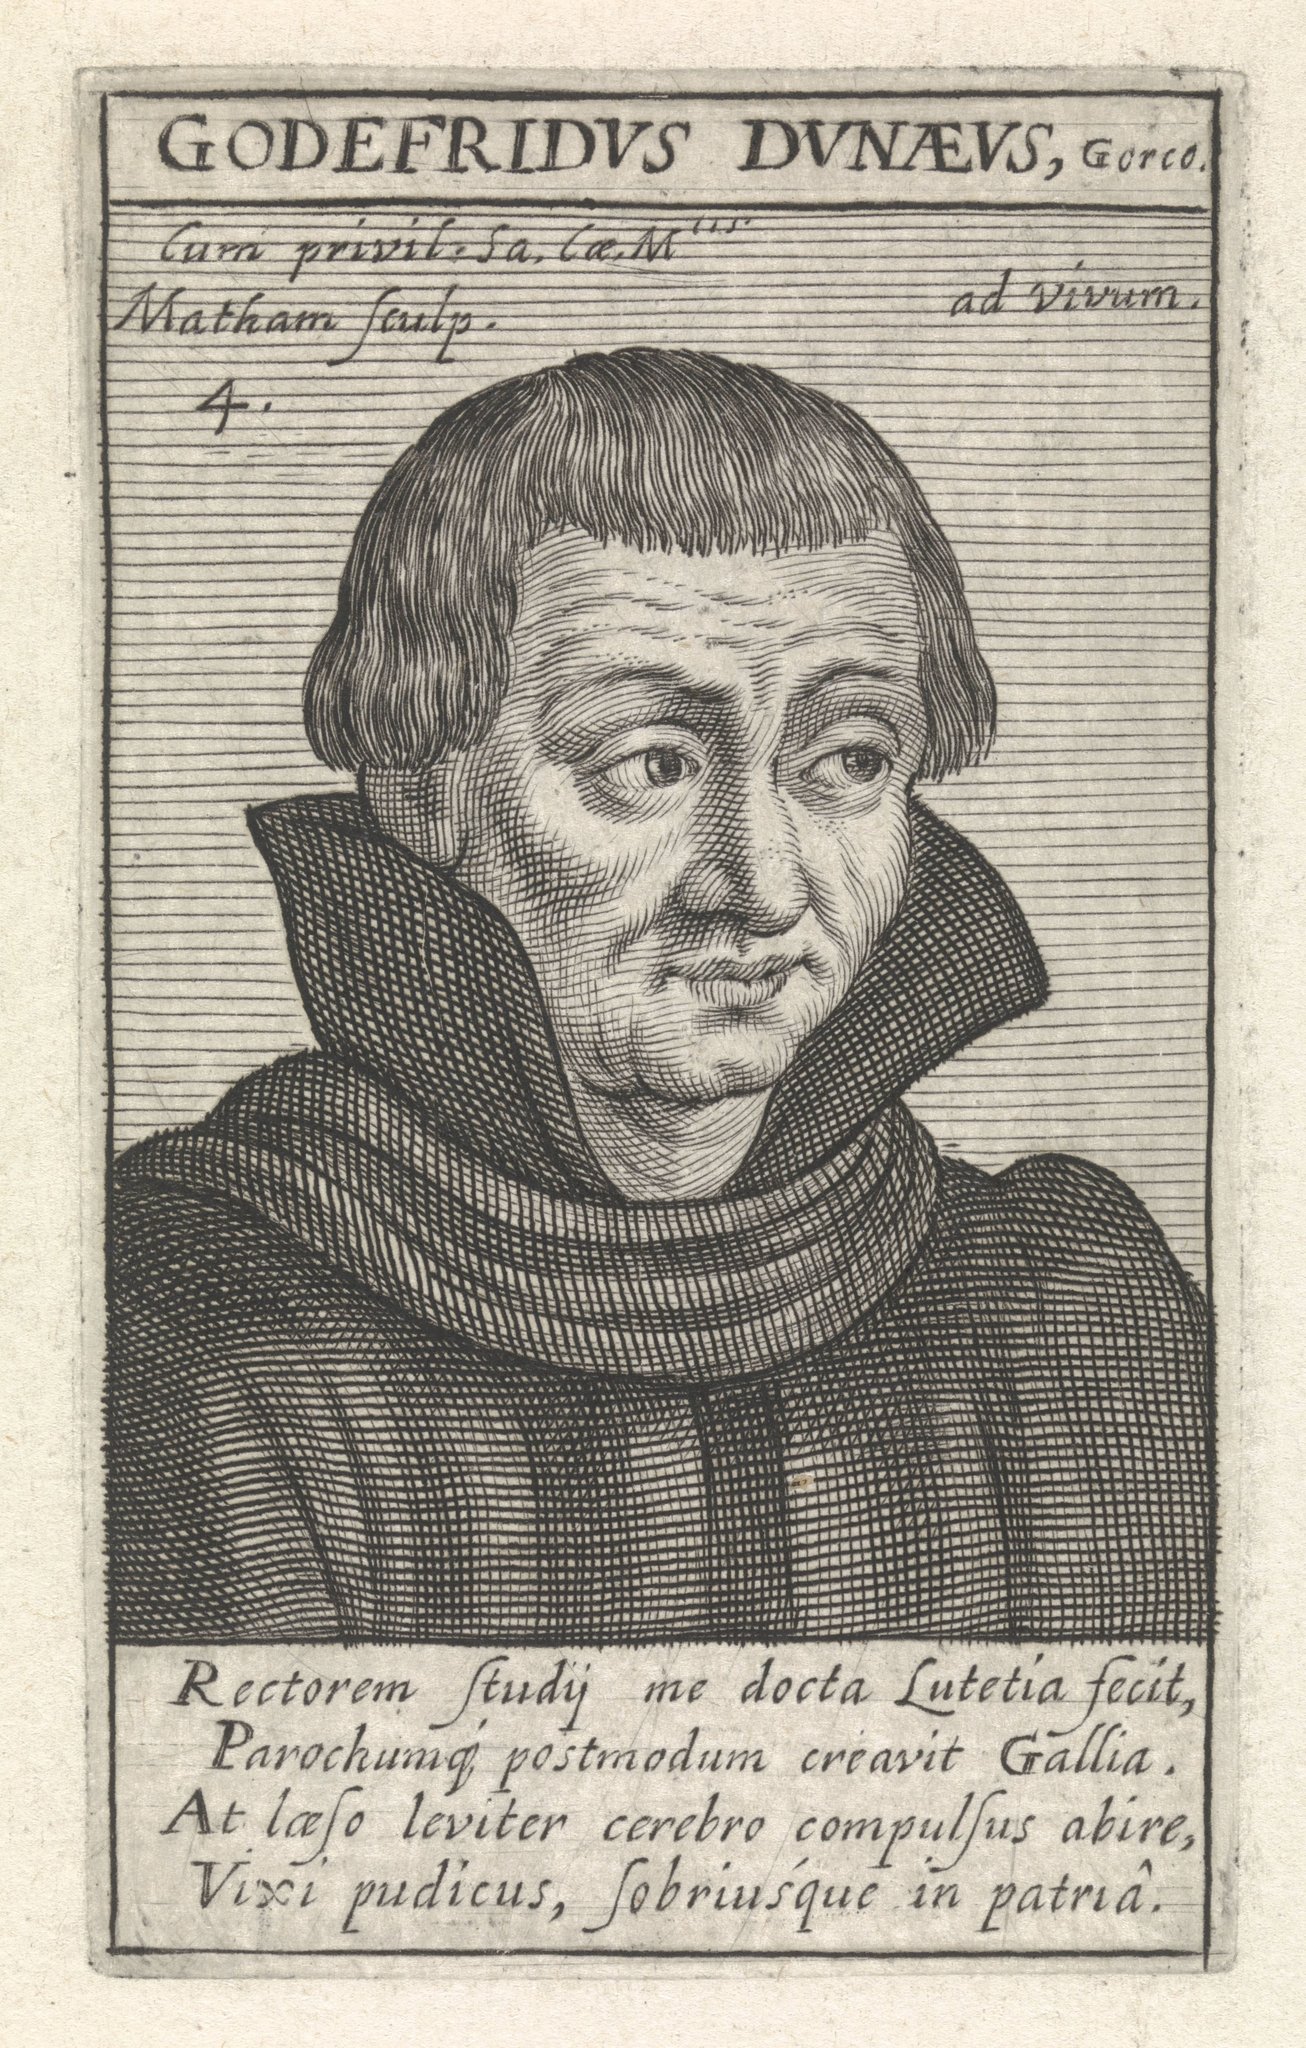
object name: print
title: Portret van H. Godfried van Duynen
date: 1617-1618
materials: paper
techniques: engraving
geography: haarlem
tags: brielle, martyrs of gorkum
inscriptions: collector's mark: Lugt 2228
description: Portret van de heilige Godfried van Duynen, een van de negentien katholieke martelaren van Gorinchem.